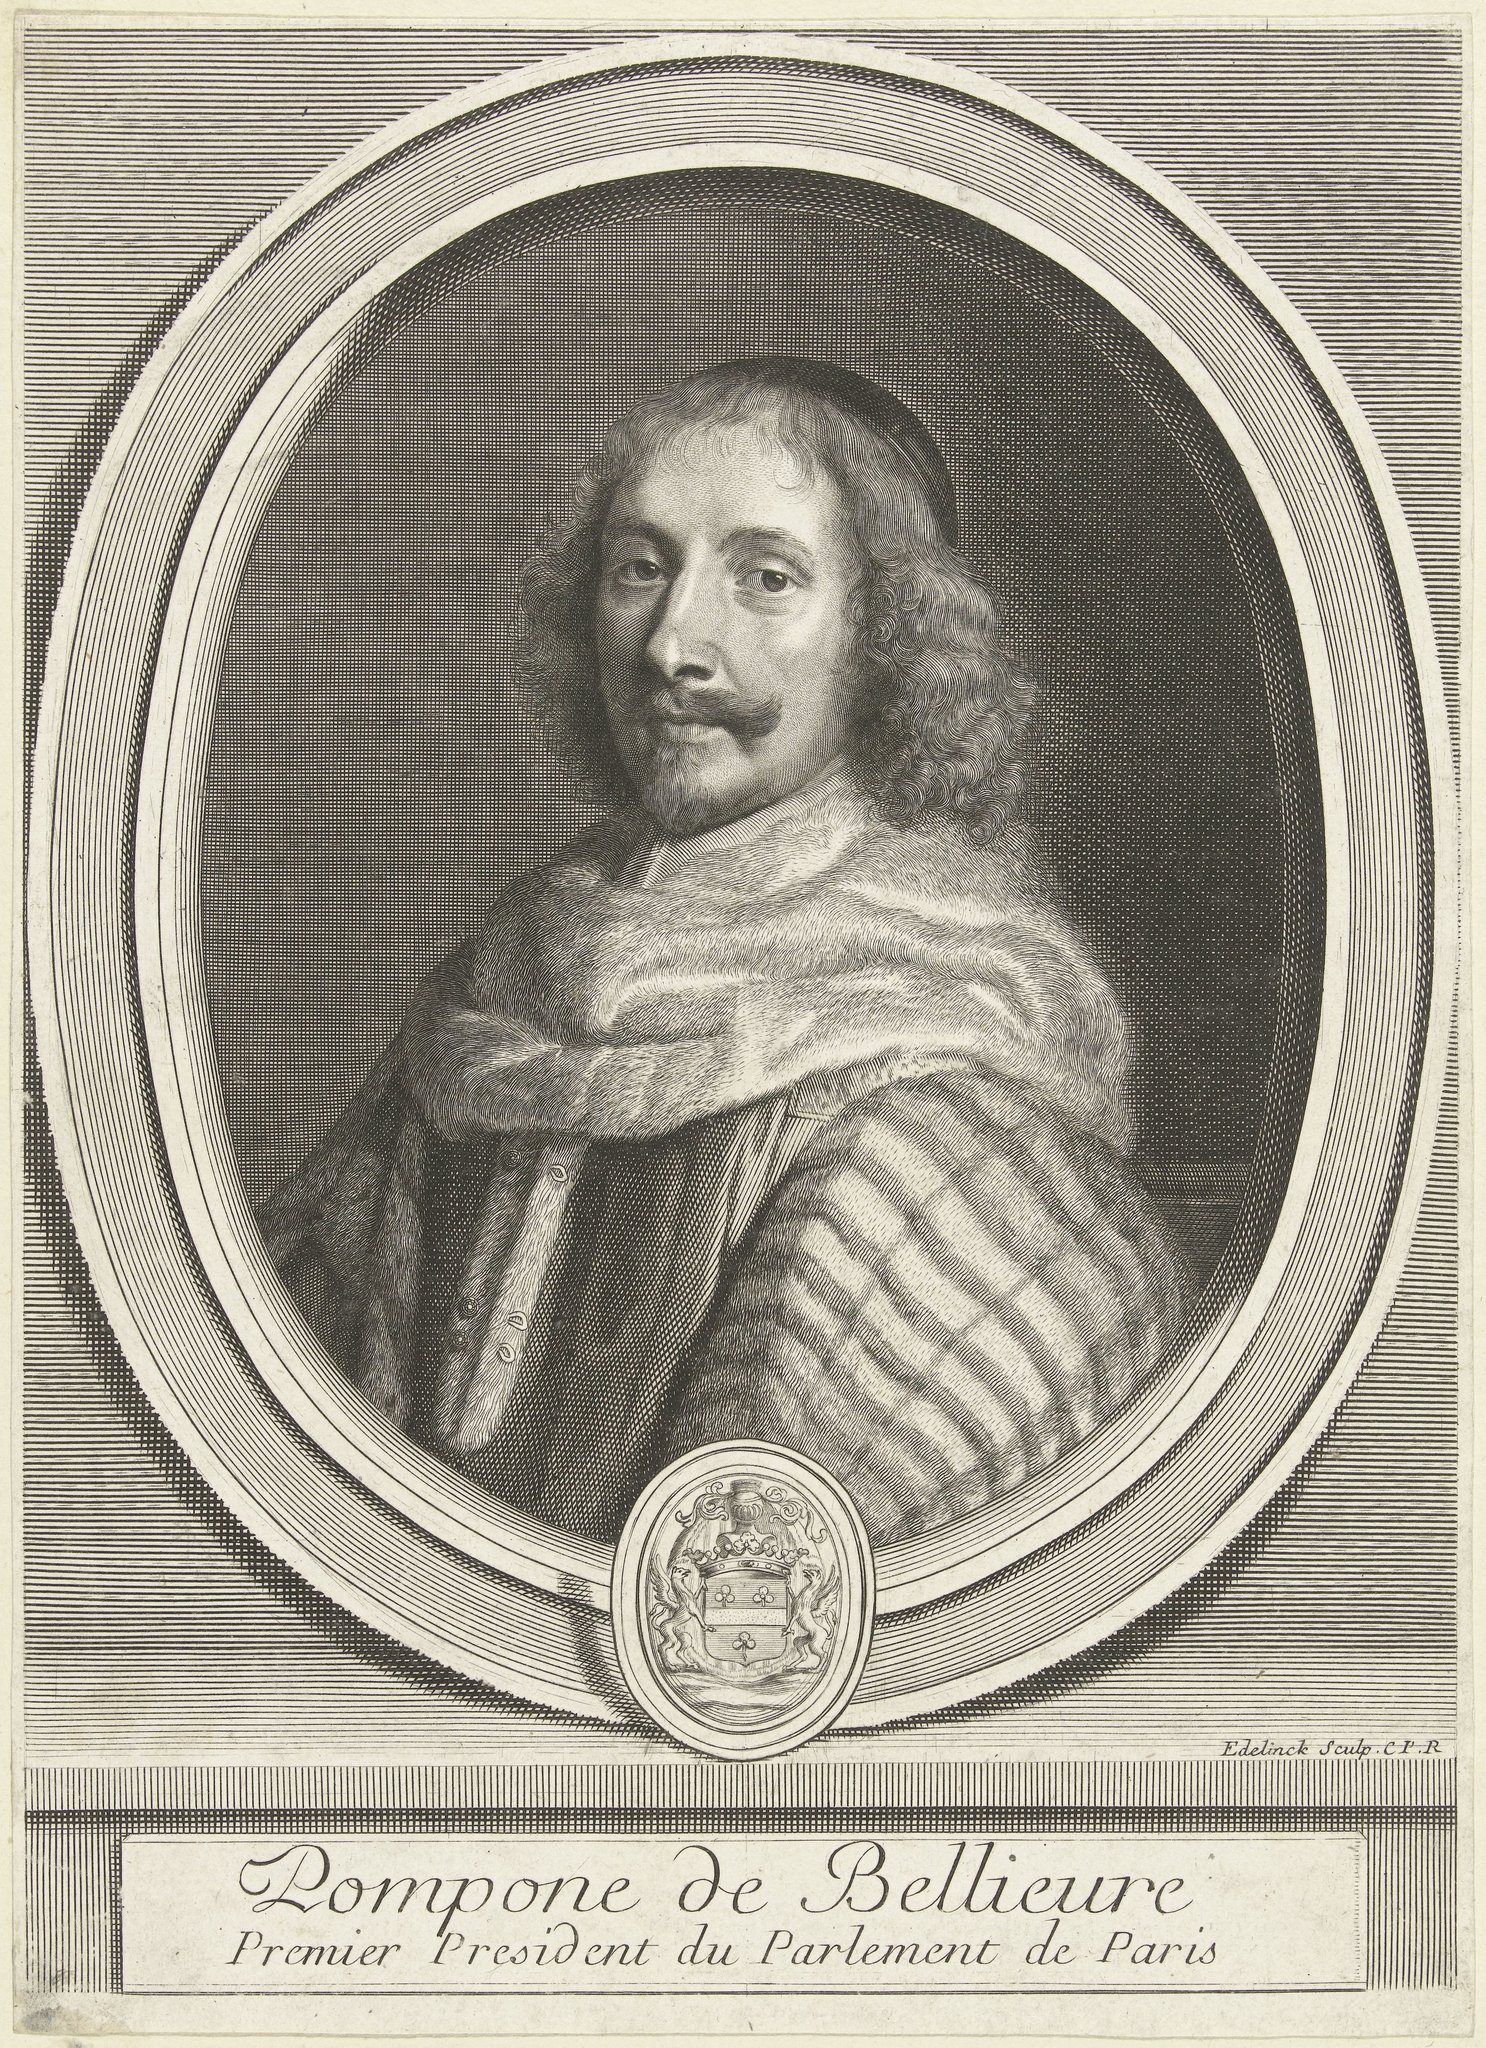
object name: print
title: Pompone de Bellieure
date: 1666-1707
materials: paper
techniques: engraving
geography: paris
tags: pompone ii de bellièvre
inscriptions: collector's mark: Lugt 2228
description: Portret van Pompone de Bellièvre (1606-1657), eerste president van het Parijse parlement, afgebeeld in ovale omlijsting met wapen.